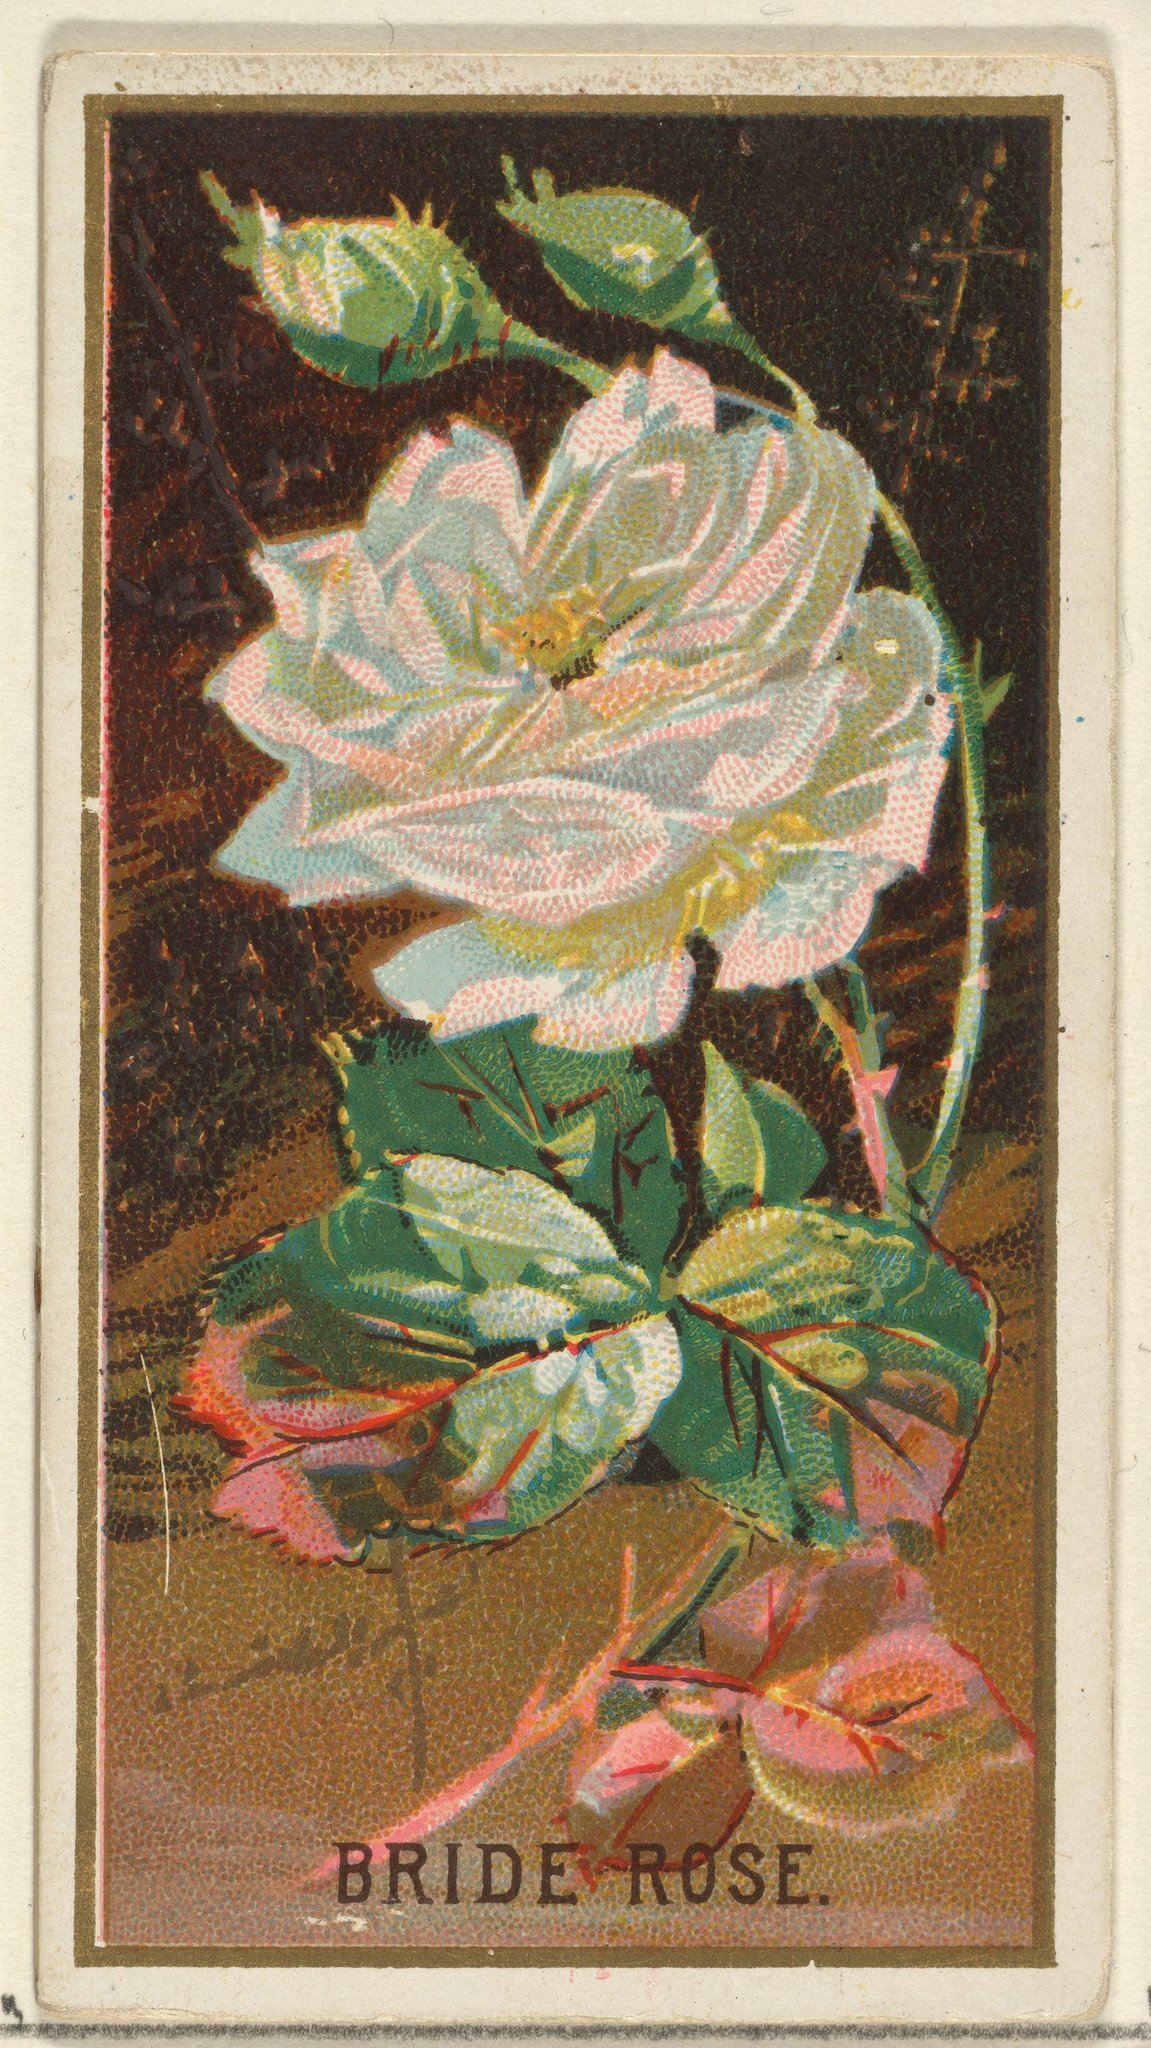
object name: print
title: Bride Rose, from the Flowers series for Old Judge Cigarettes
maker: goodwin & company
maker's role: publisher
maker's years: 1850-1950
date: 1890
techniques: color lithograph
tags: flowers,leaves